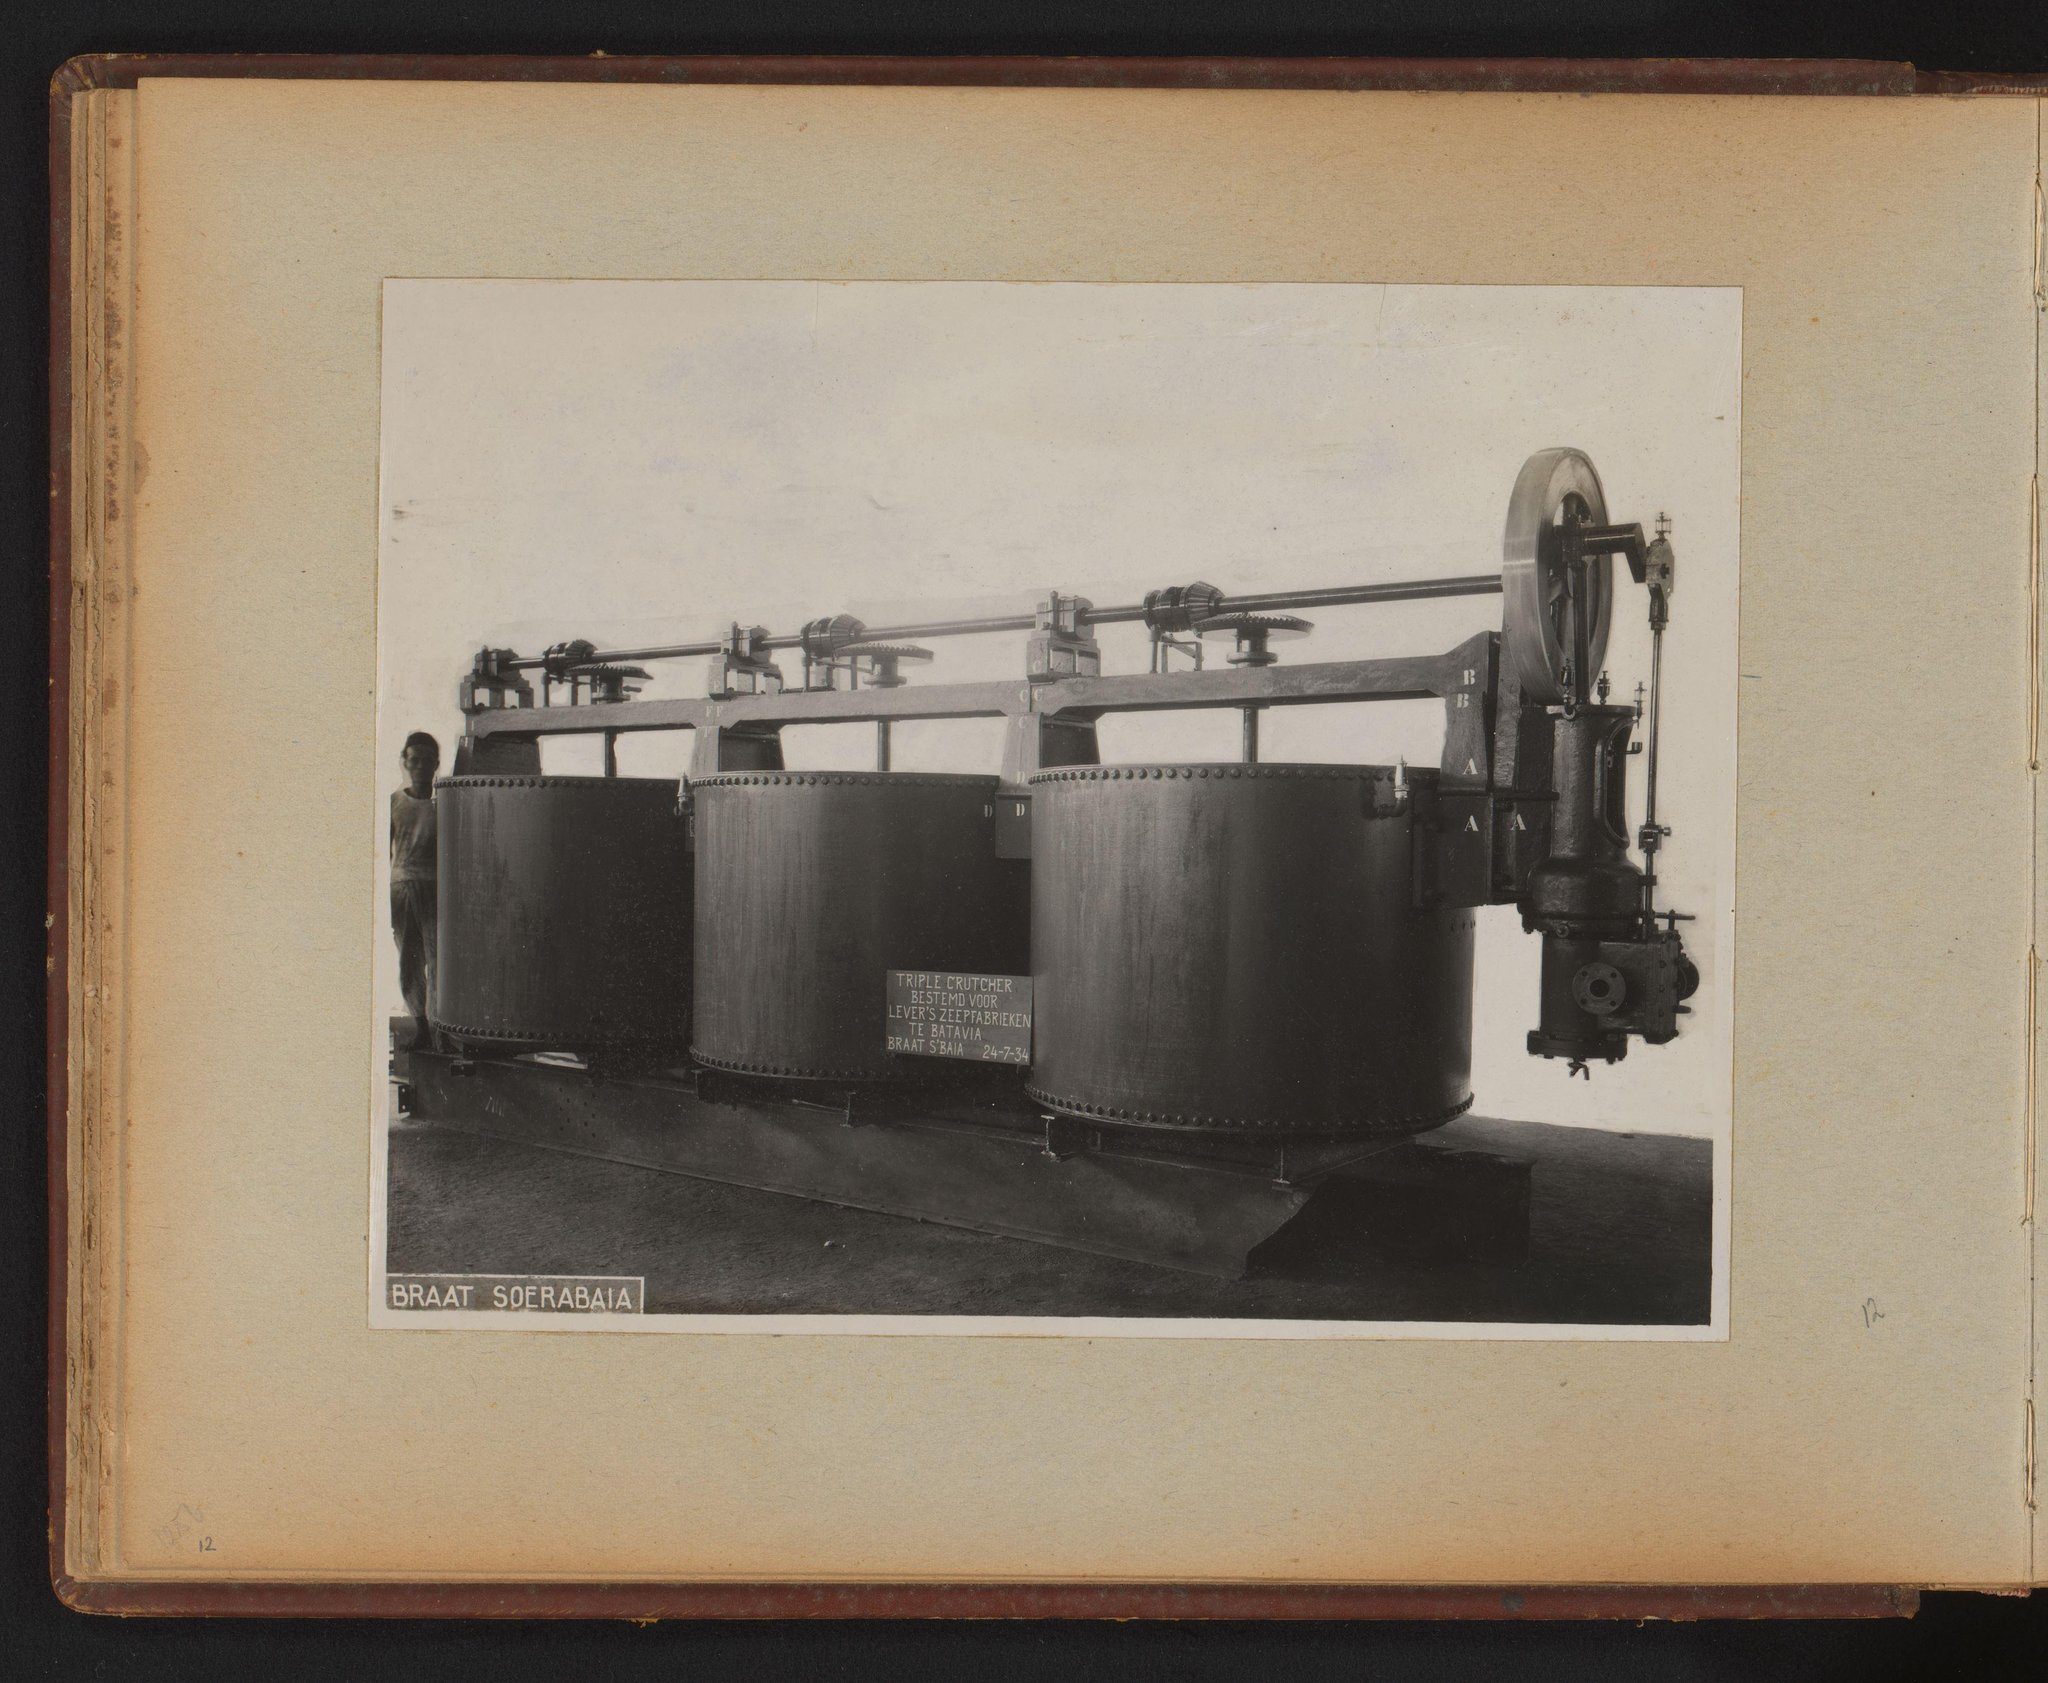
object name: photograph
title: Triple Crutcher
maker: Anonymous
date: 1934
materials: cardboard, photographic support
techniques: gelatin silver print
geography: surabaya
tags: machines; parts of machines; tools and appliances, java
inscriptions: date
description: Albumblad met een foto van een 'Triple Crutcher', vervaardigd in 1934 en bestemd voor Lever's Zeepfabrieken te Batavia. Onderdeel van een fotoalbum met foto's van machines en constructies van de N.V. Machinefabriek Braat te Soerabaja, Soekaboemi en Tegal uit de periode 1931-1937.